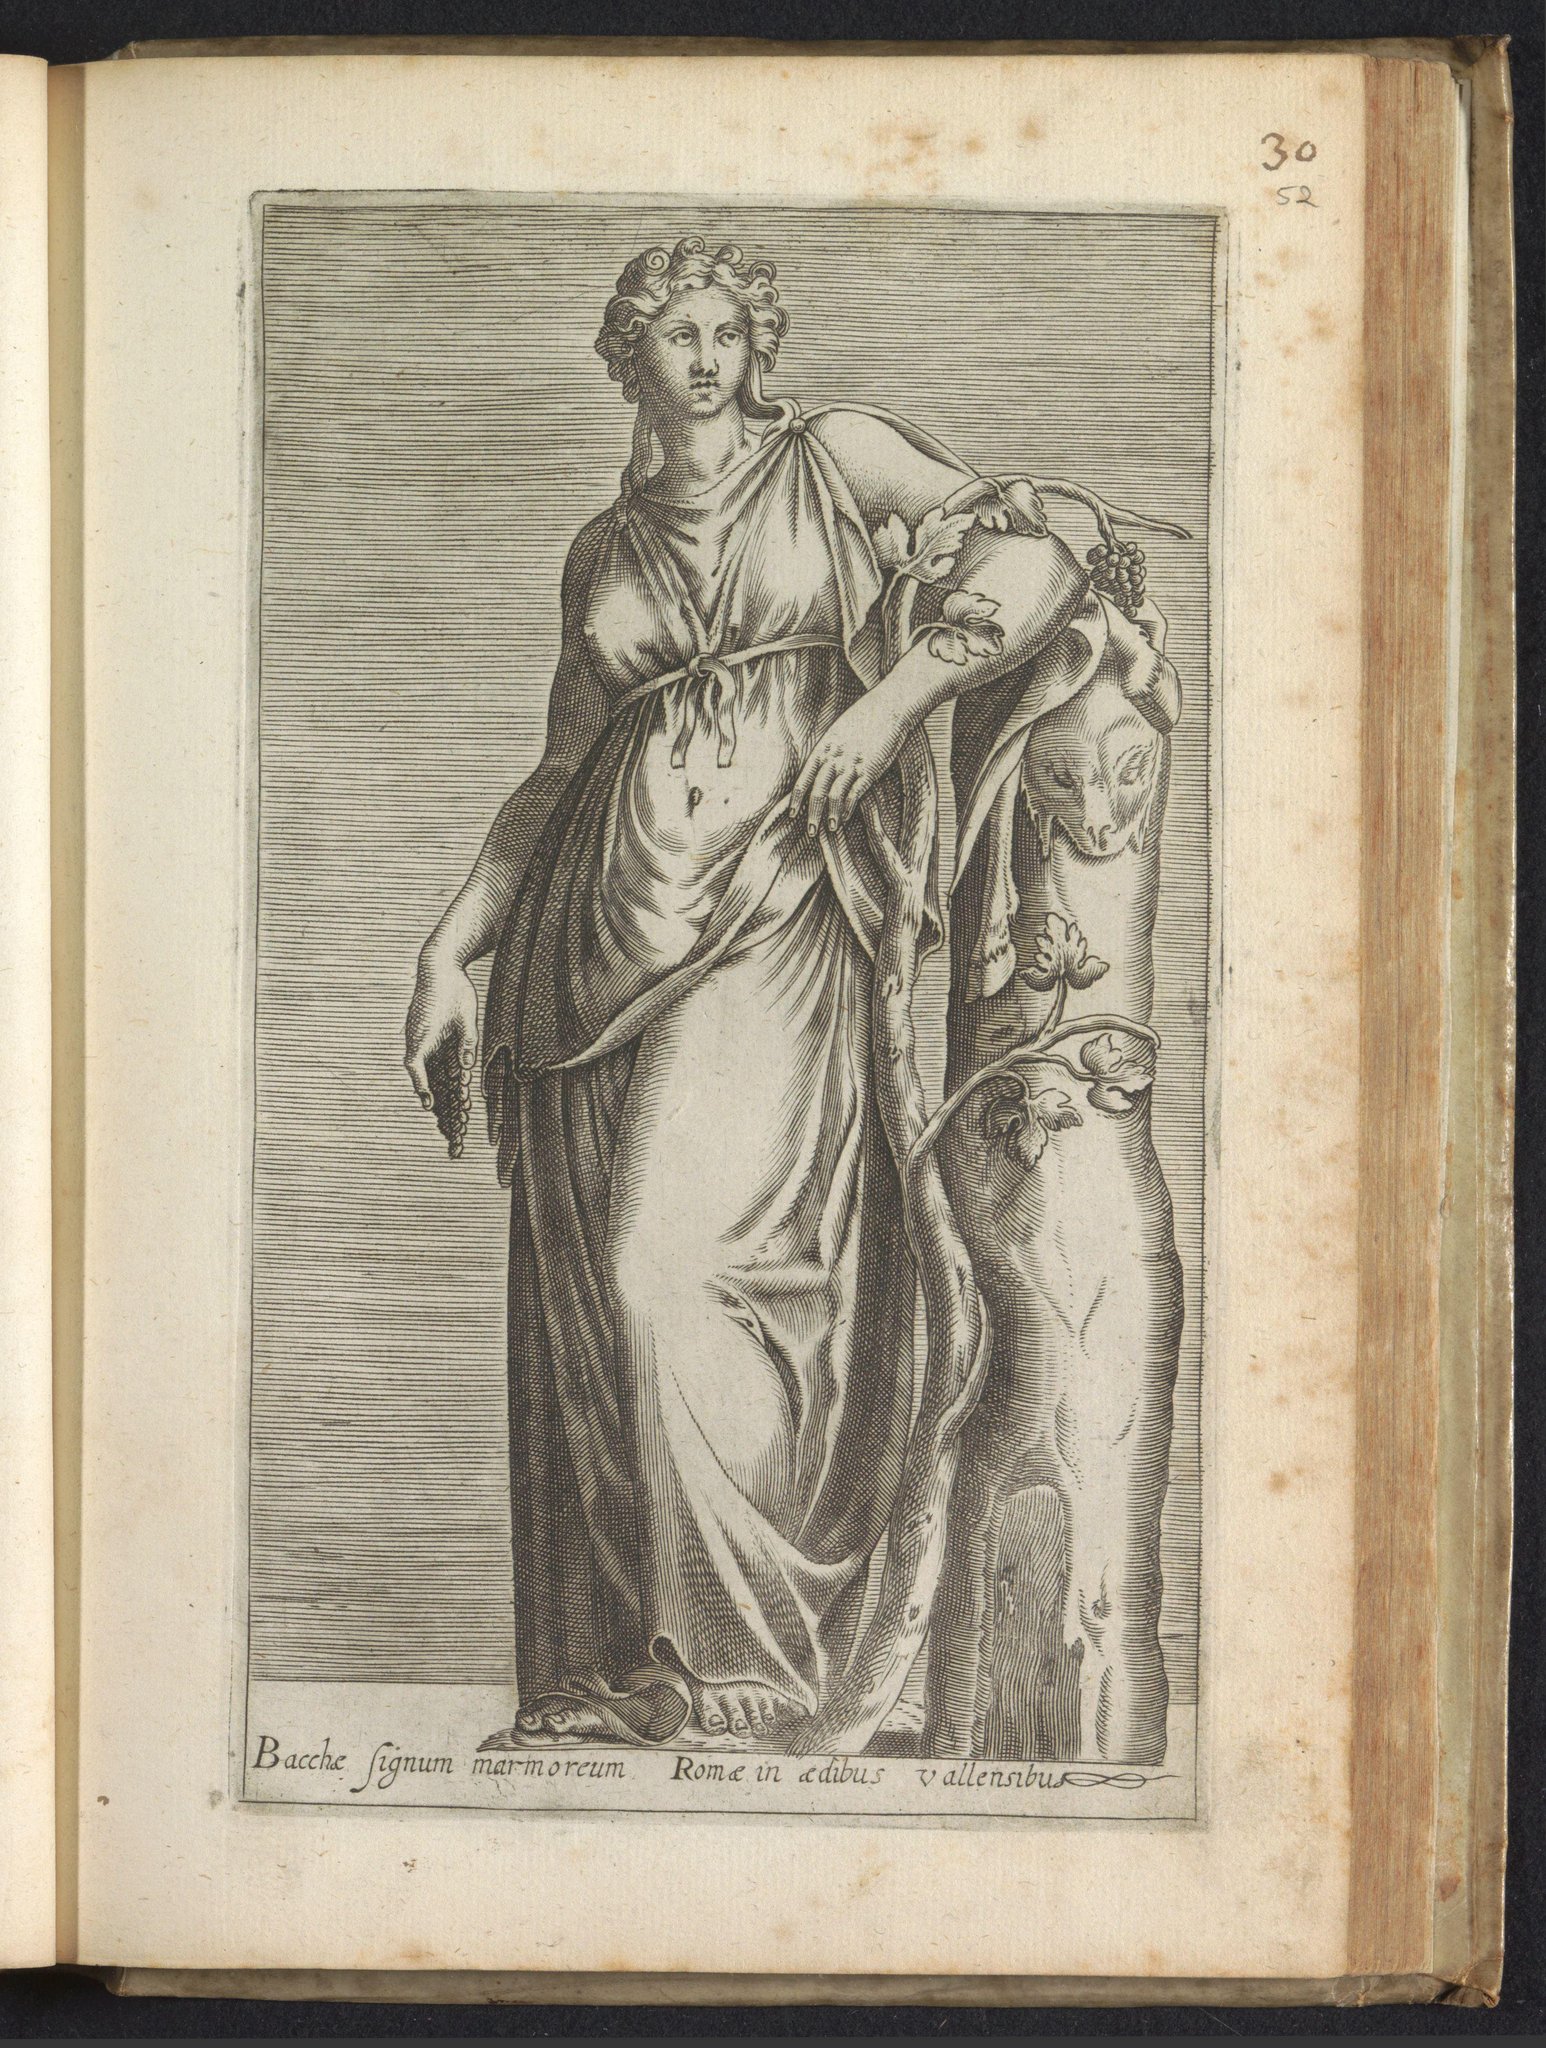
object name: print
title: Sculptuur van een Bacchante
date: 1584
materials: paper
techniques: engraving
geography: rome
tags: maenad(s), female bacchant(es), piece of sculpture, reproduction of a piece of sculpture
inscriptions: number: ‘30’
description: Deze prent maakt deel uit van een set van 79 prenten (+ titelprent) met voorstellingen van antieke sculpturen in Rome.